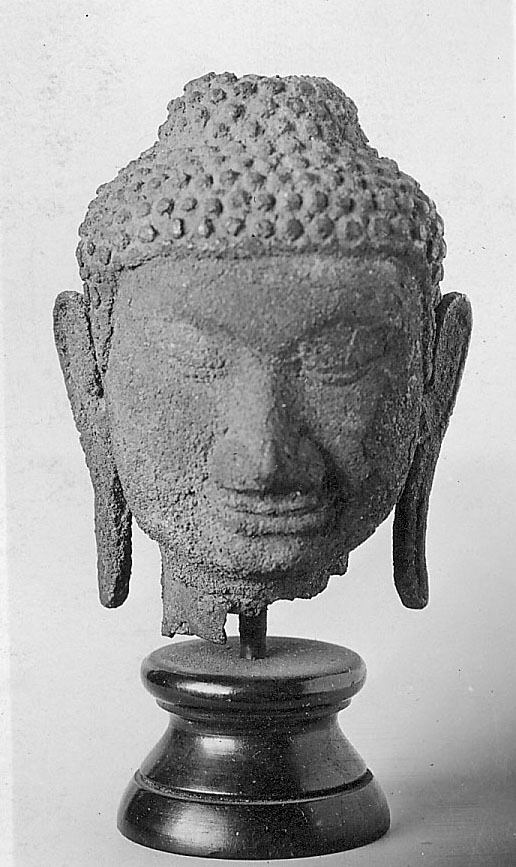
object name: head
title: Head of Buddha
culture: cambodian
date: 801-900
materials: bronze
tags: heads,buddhism,buddha